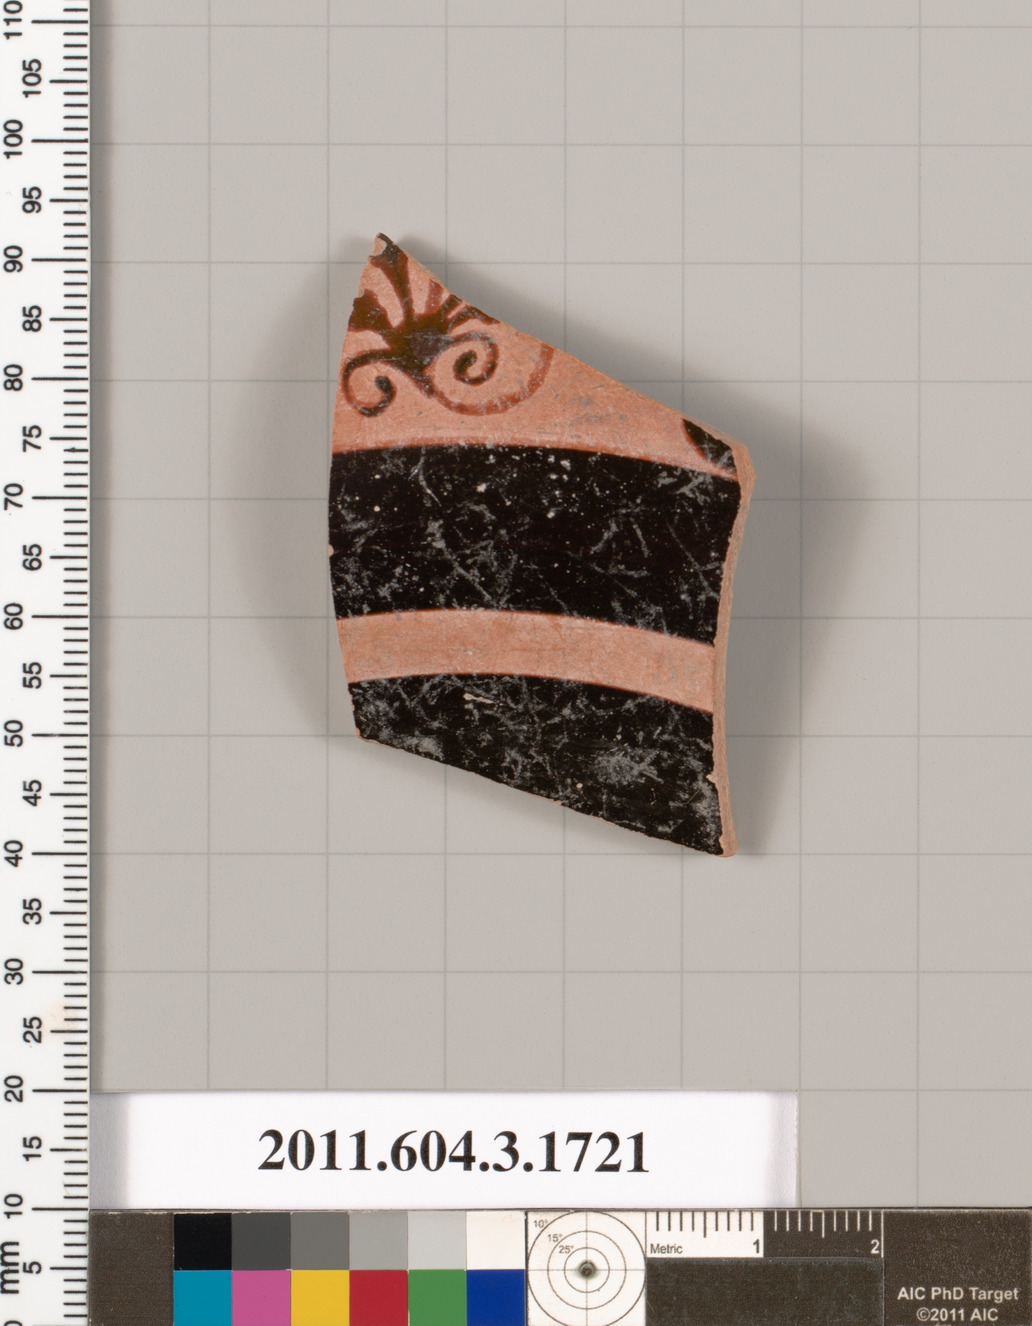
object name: kylix fragment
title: Terracotta fragment of a kylix: Lip cup (drinking cup)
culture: greek, attic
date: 550-526 BCE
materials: terracotta